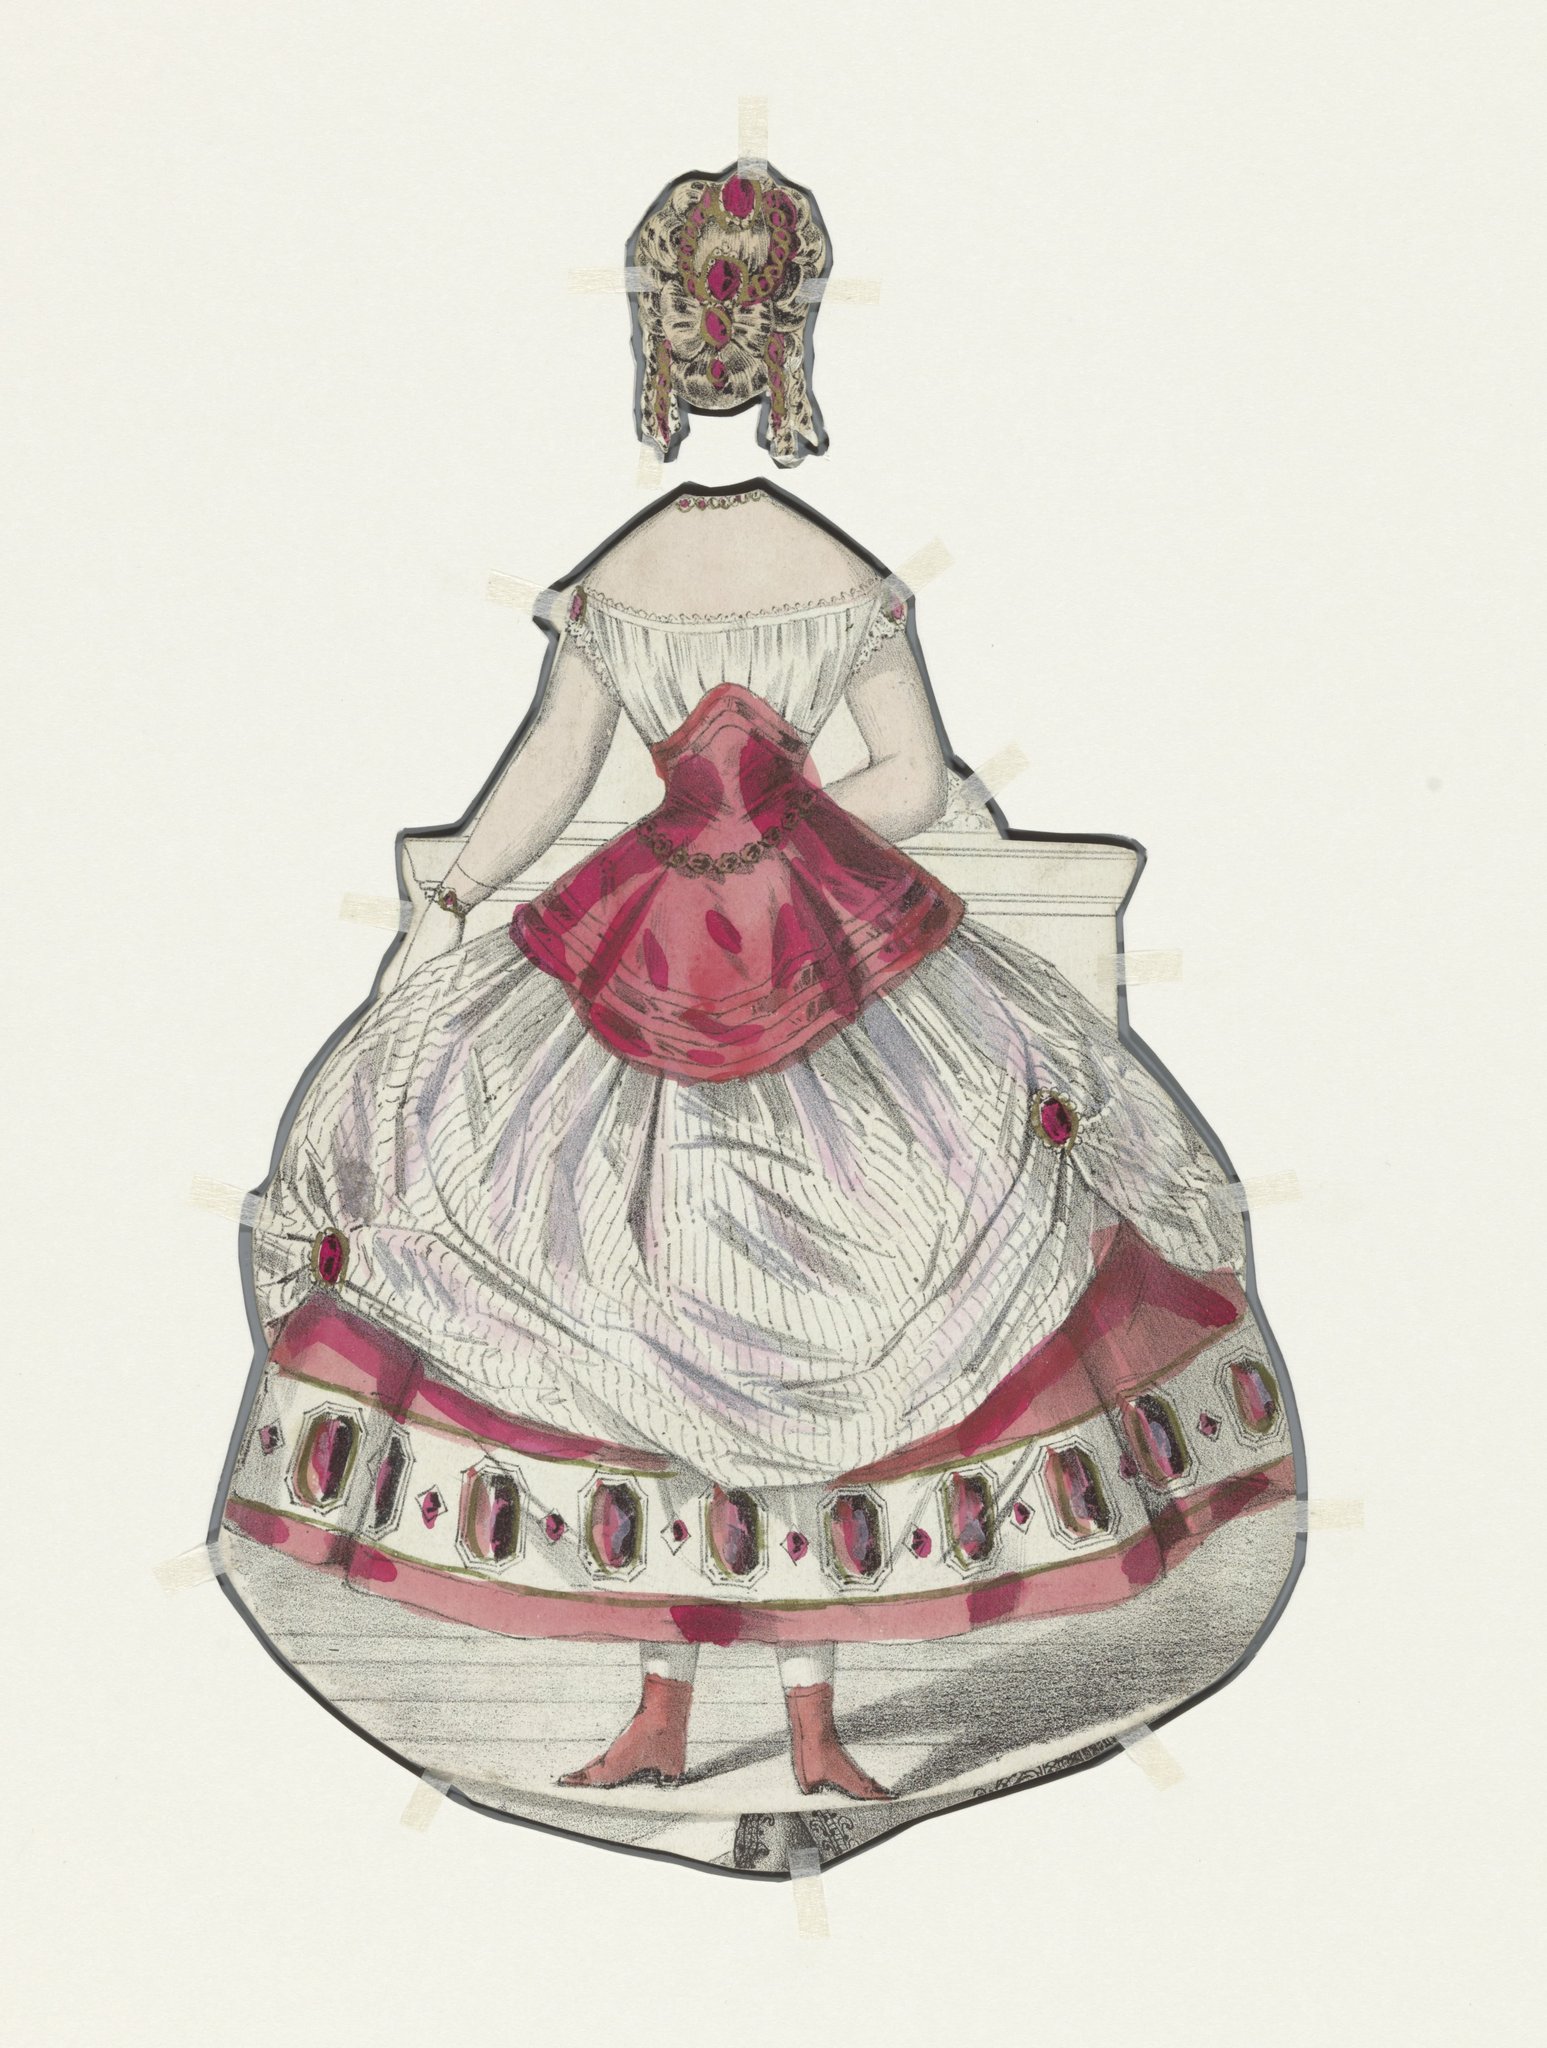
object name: fashion print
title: Achterzijde van een jurk voor een uitknippop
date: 1825-1875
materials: paper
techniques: engraving, hand coloring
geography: paris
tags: fashion plates